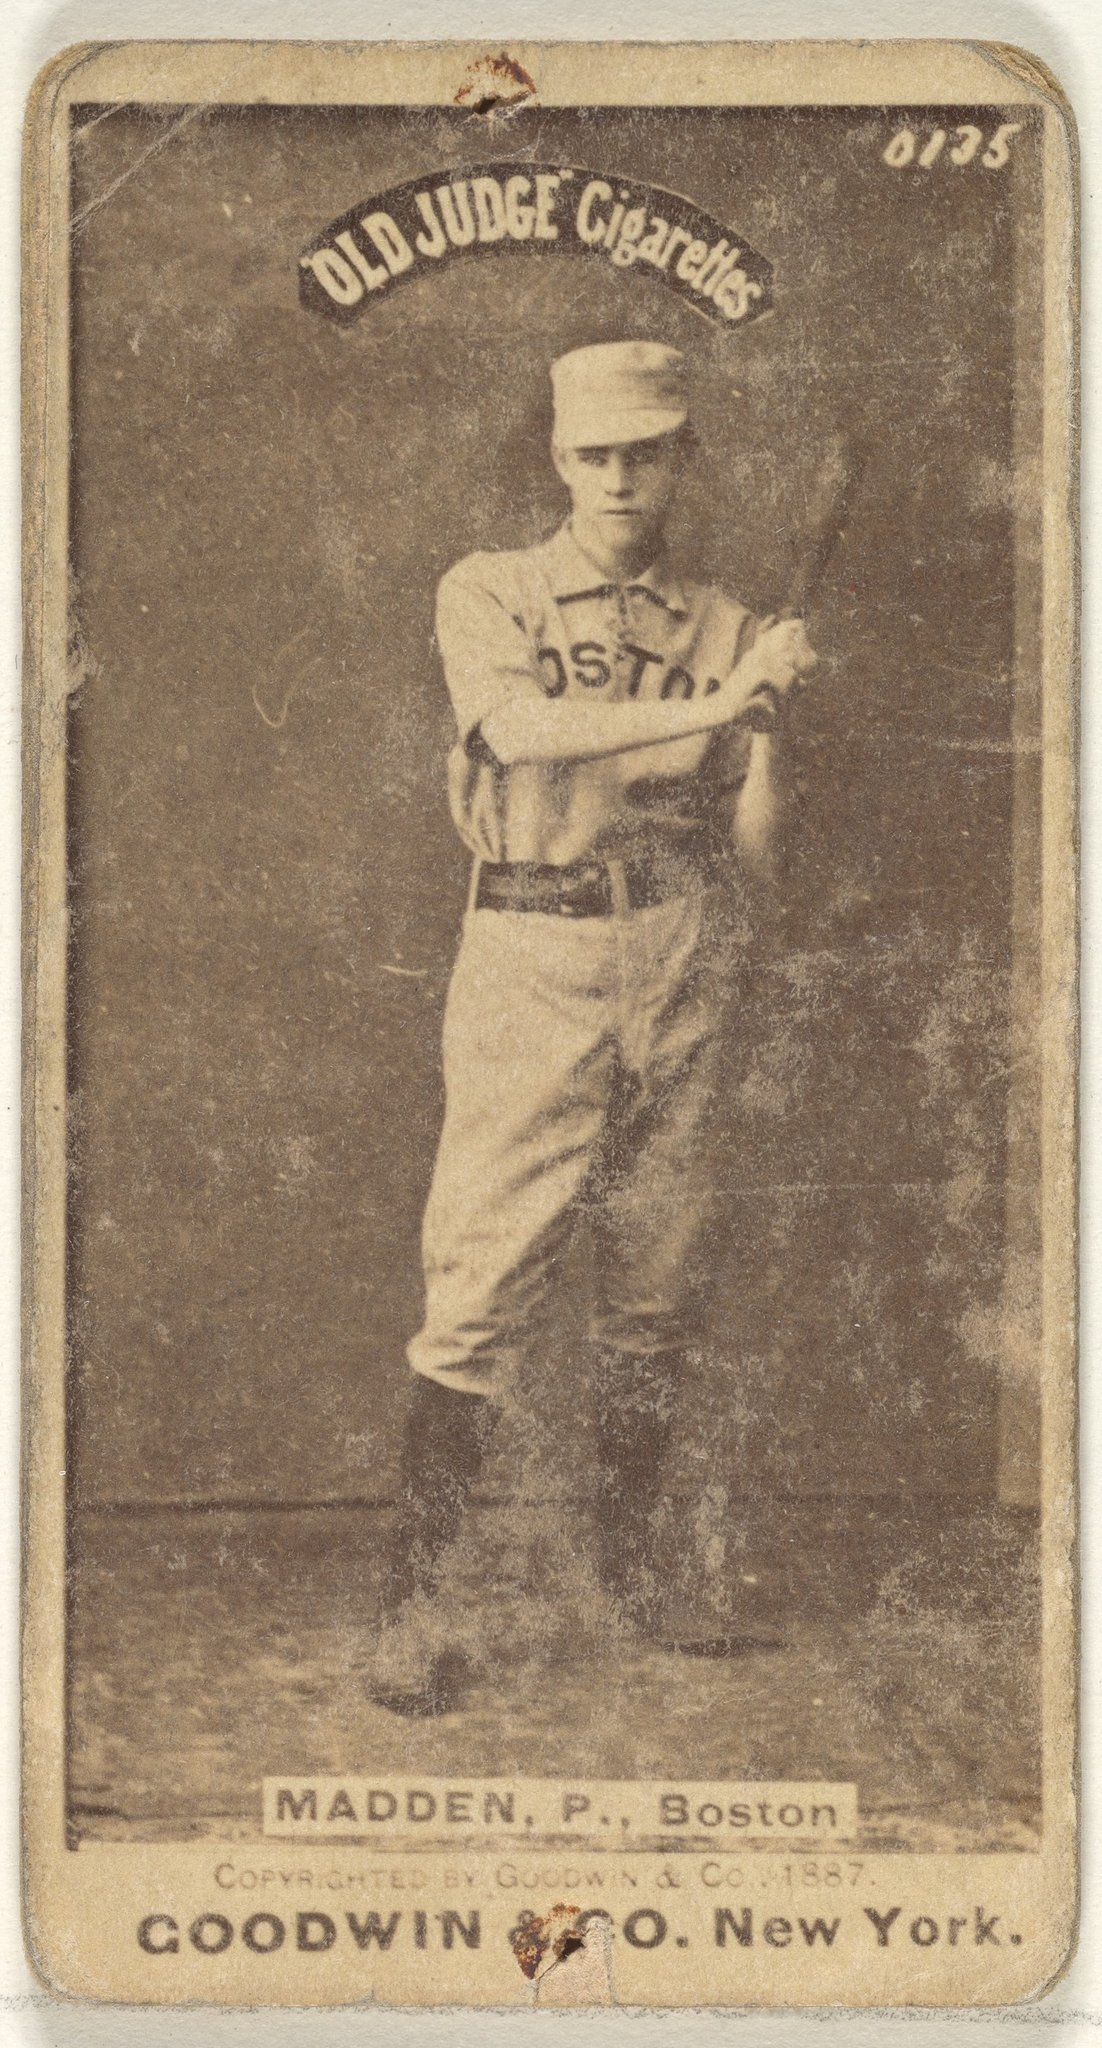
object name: baseball card, photograph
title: Madden, Pitcher, Boston, from the Old Judge series (N172) for Old Judge Cigarettes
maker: goodwin & company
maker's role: publisher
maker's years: 1850-1950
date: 1887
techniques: albumen silver print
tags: men,portraits,baseball,athletes